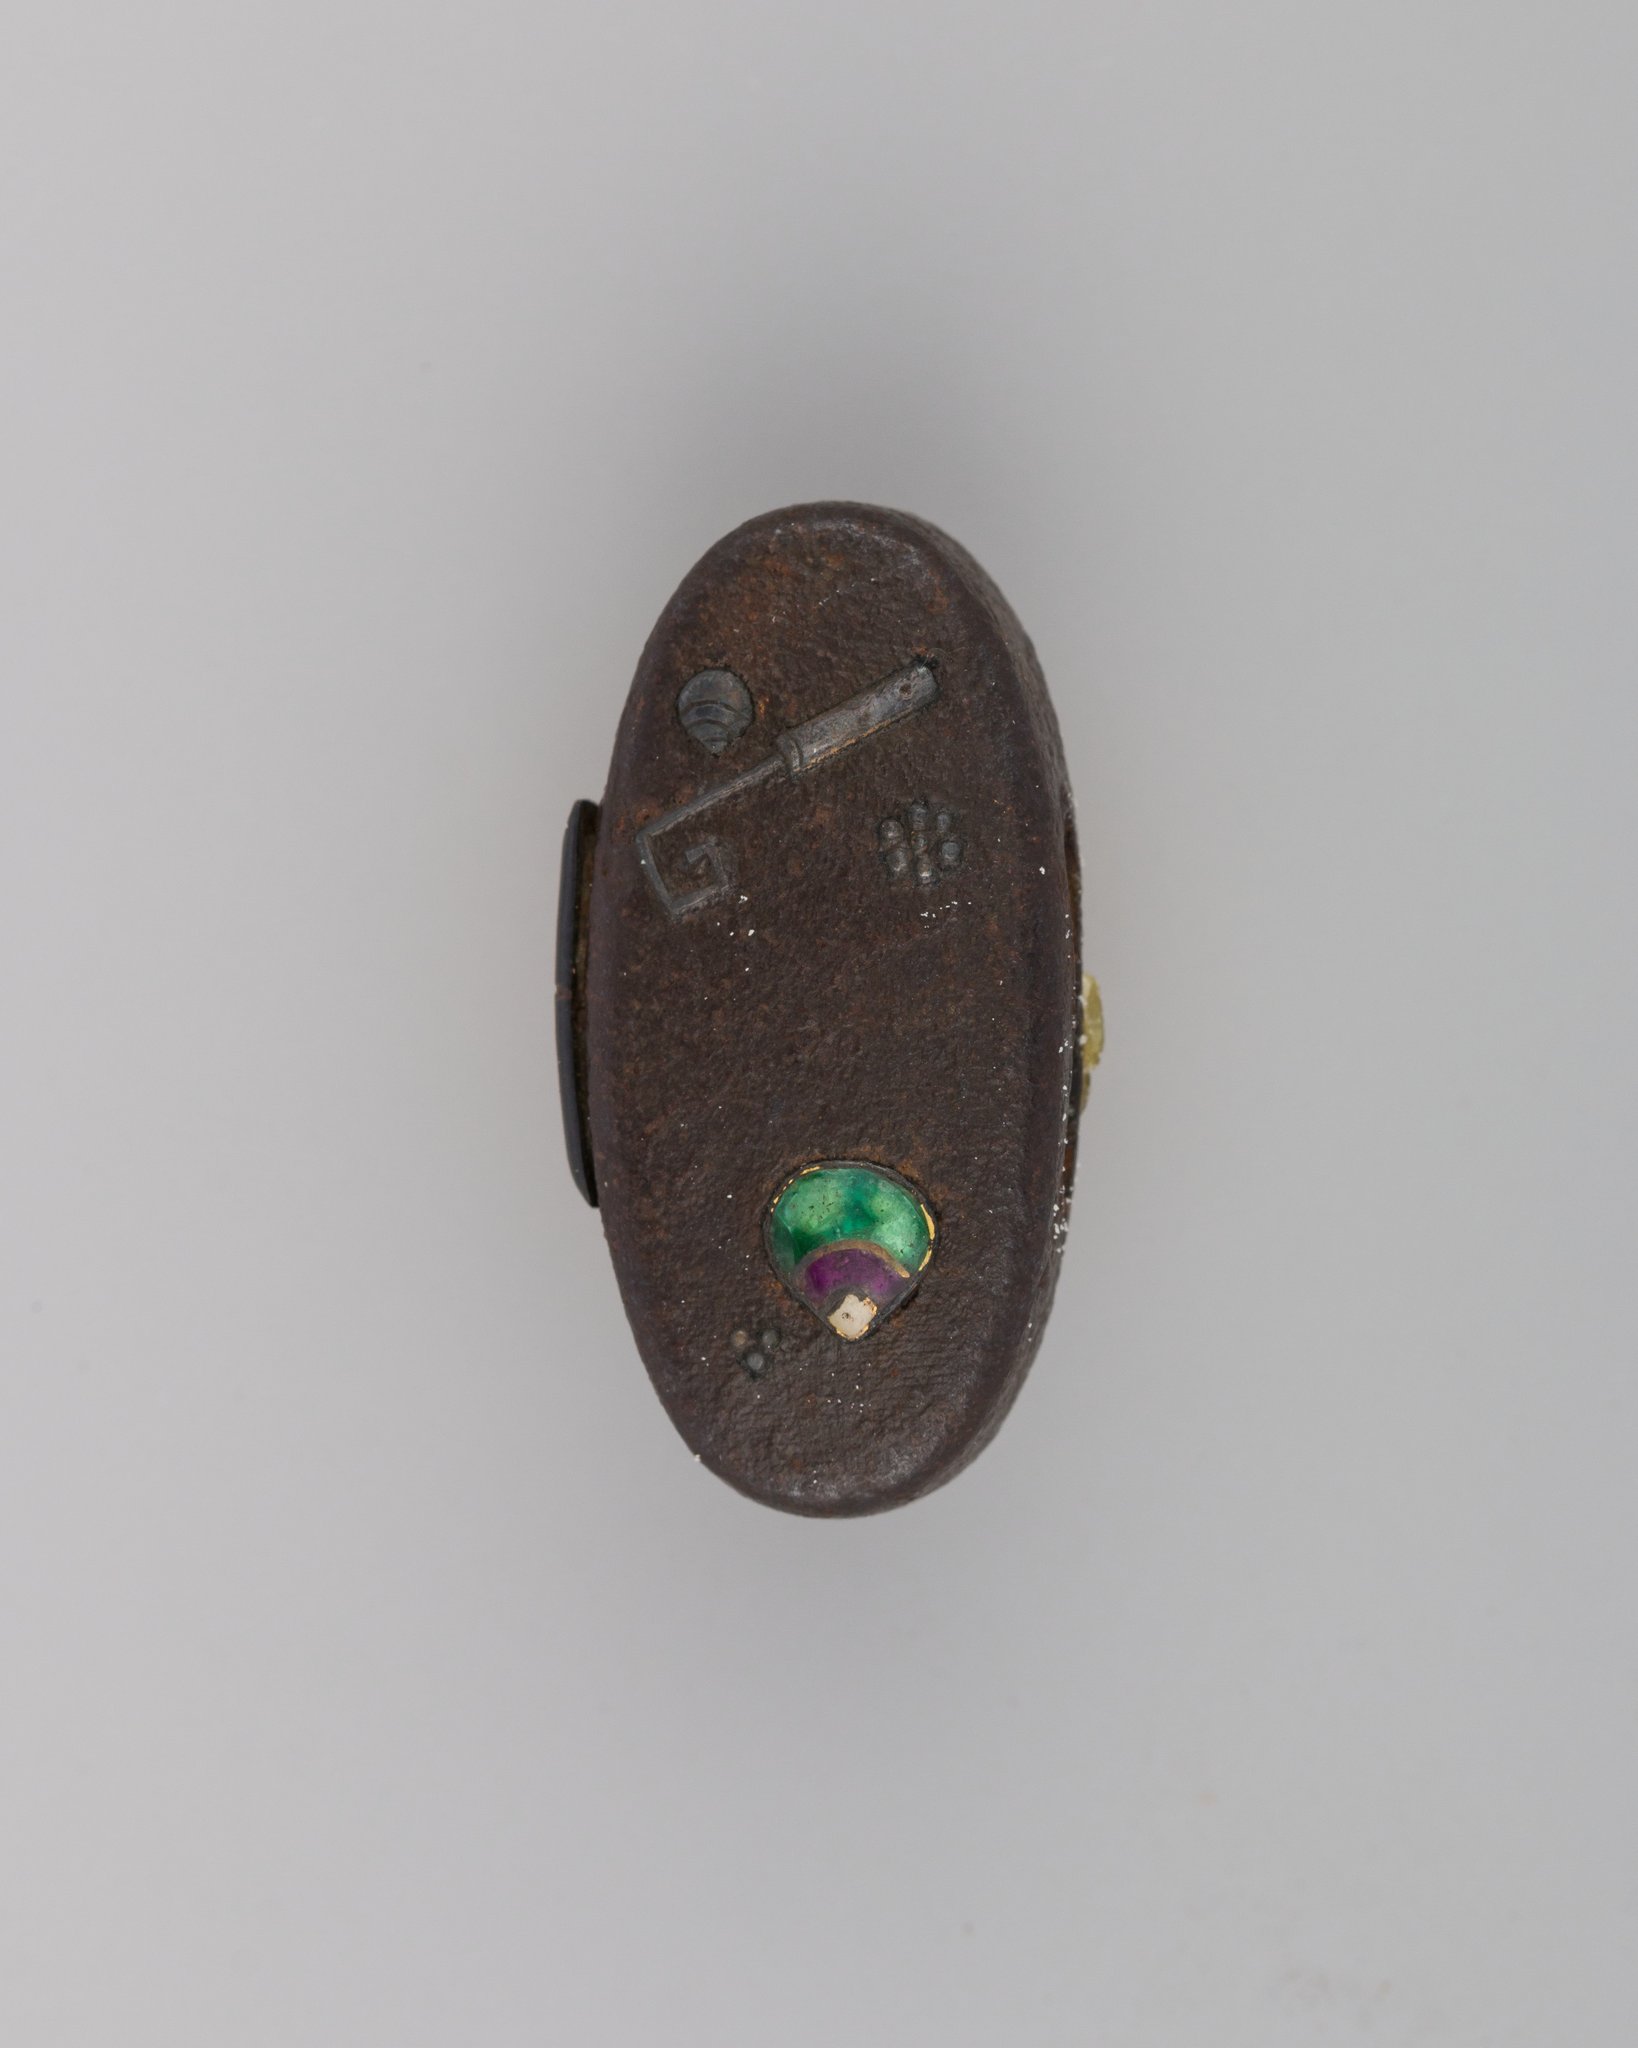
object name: sword pommel kashira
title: Sword Pommel (Kashira)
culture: japanese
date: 1615-1868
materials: enamel, gold, iron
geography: japan